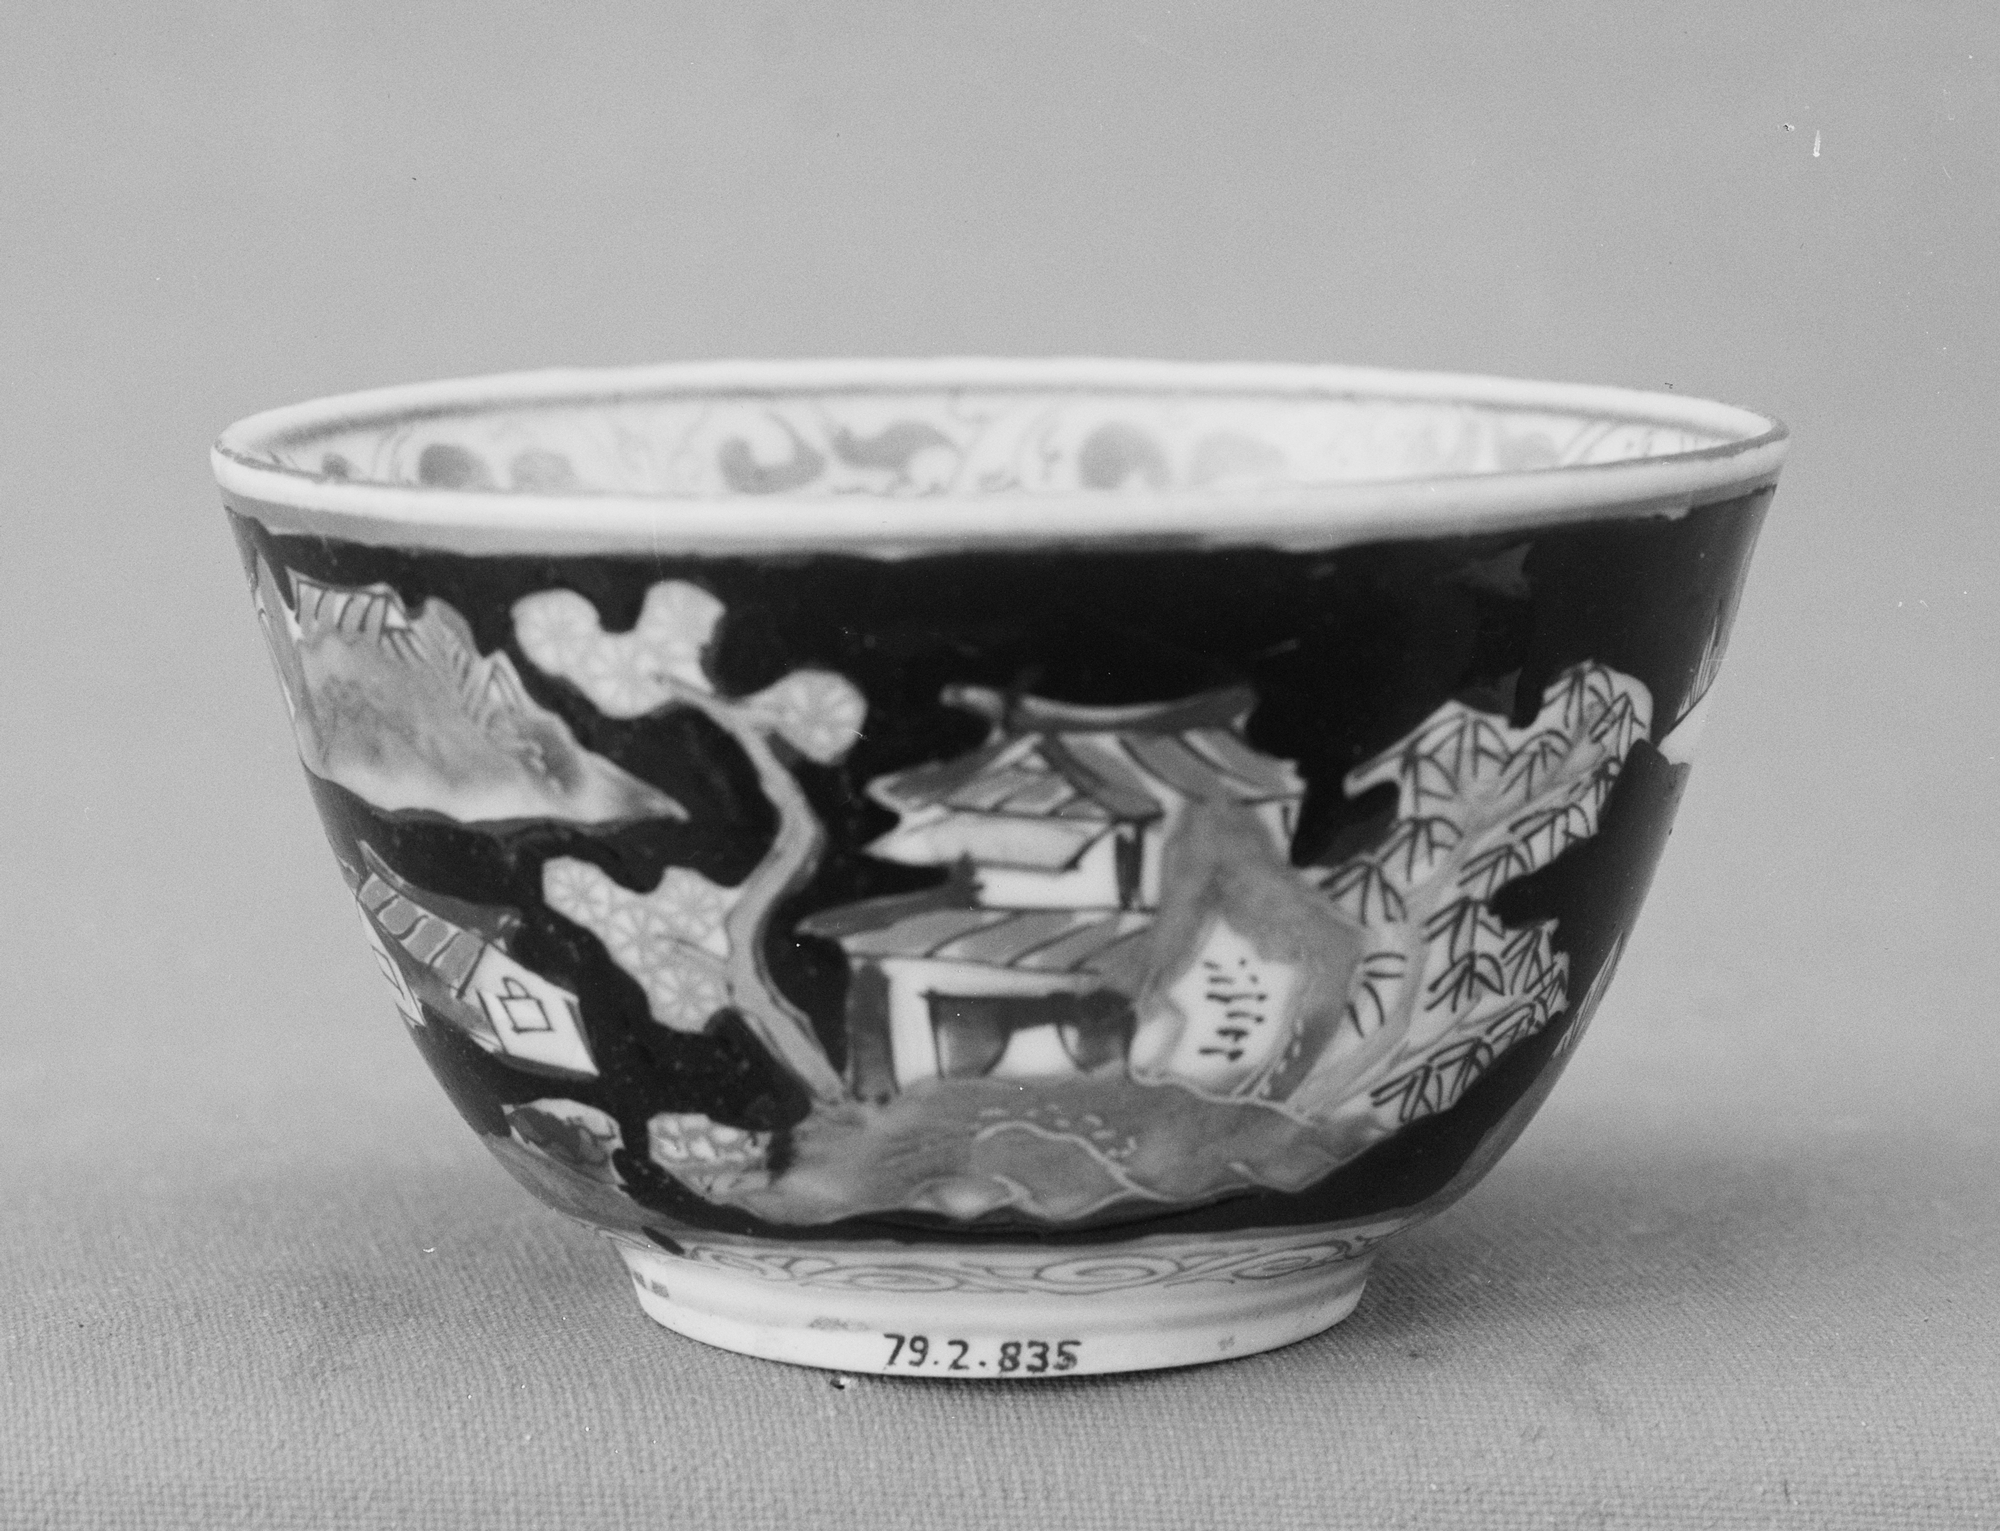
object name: cup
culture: japanese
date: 1701-1800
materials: glaze, porcelain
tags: houses